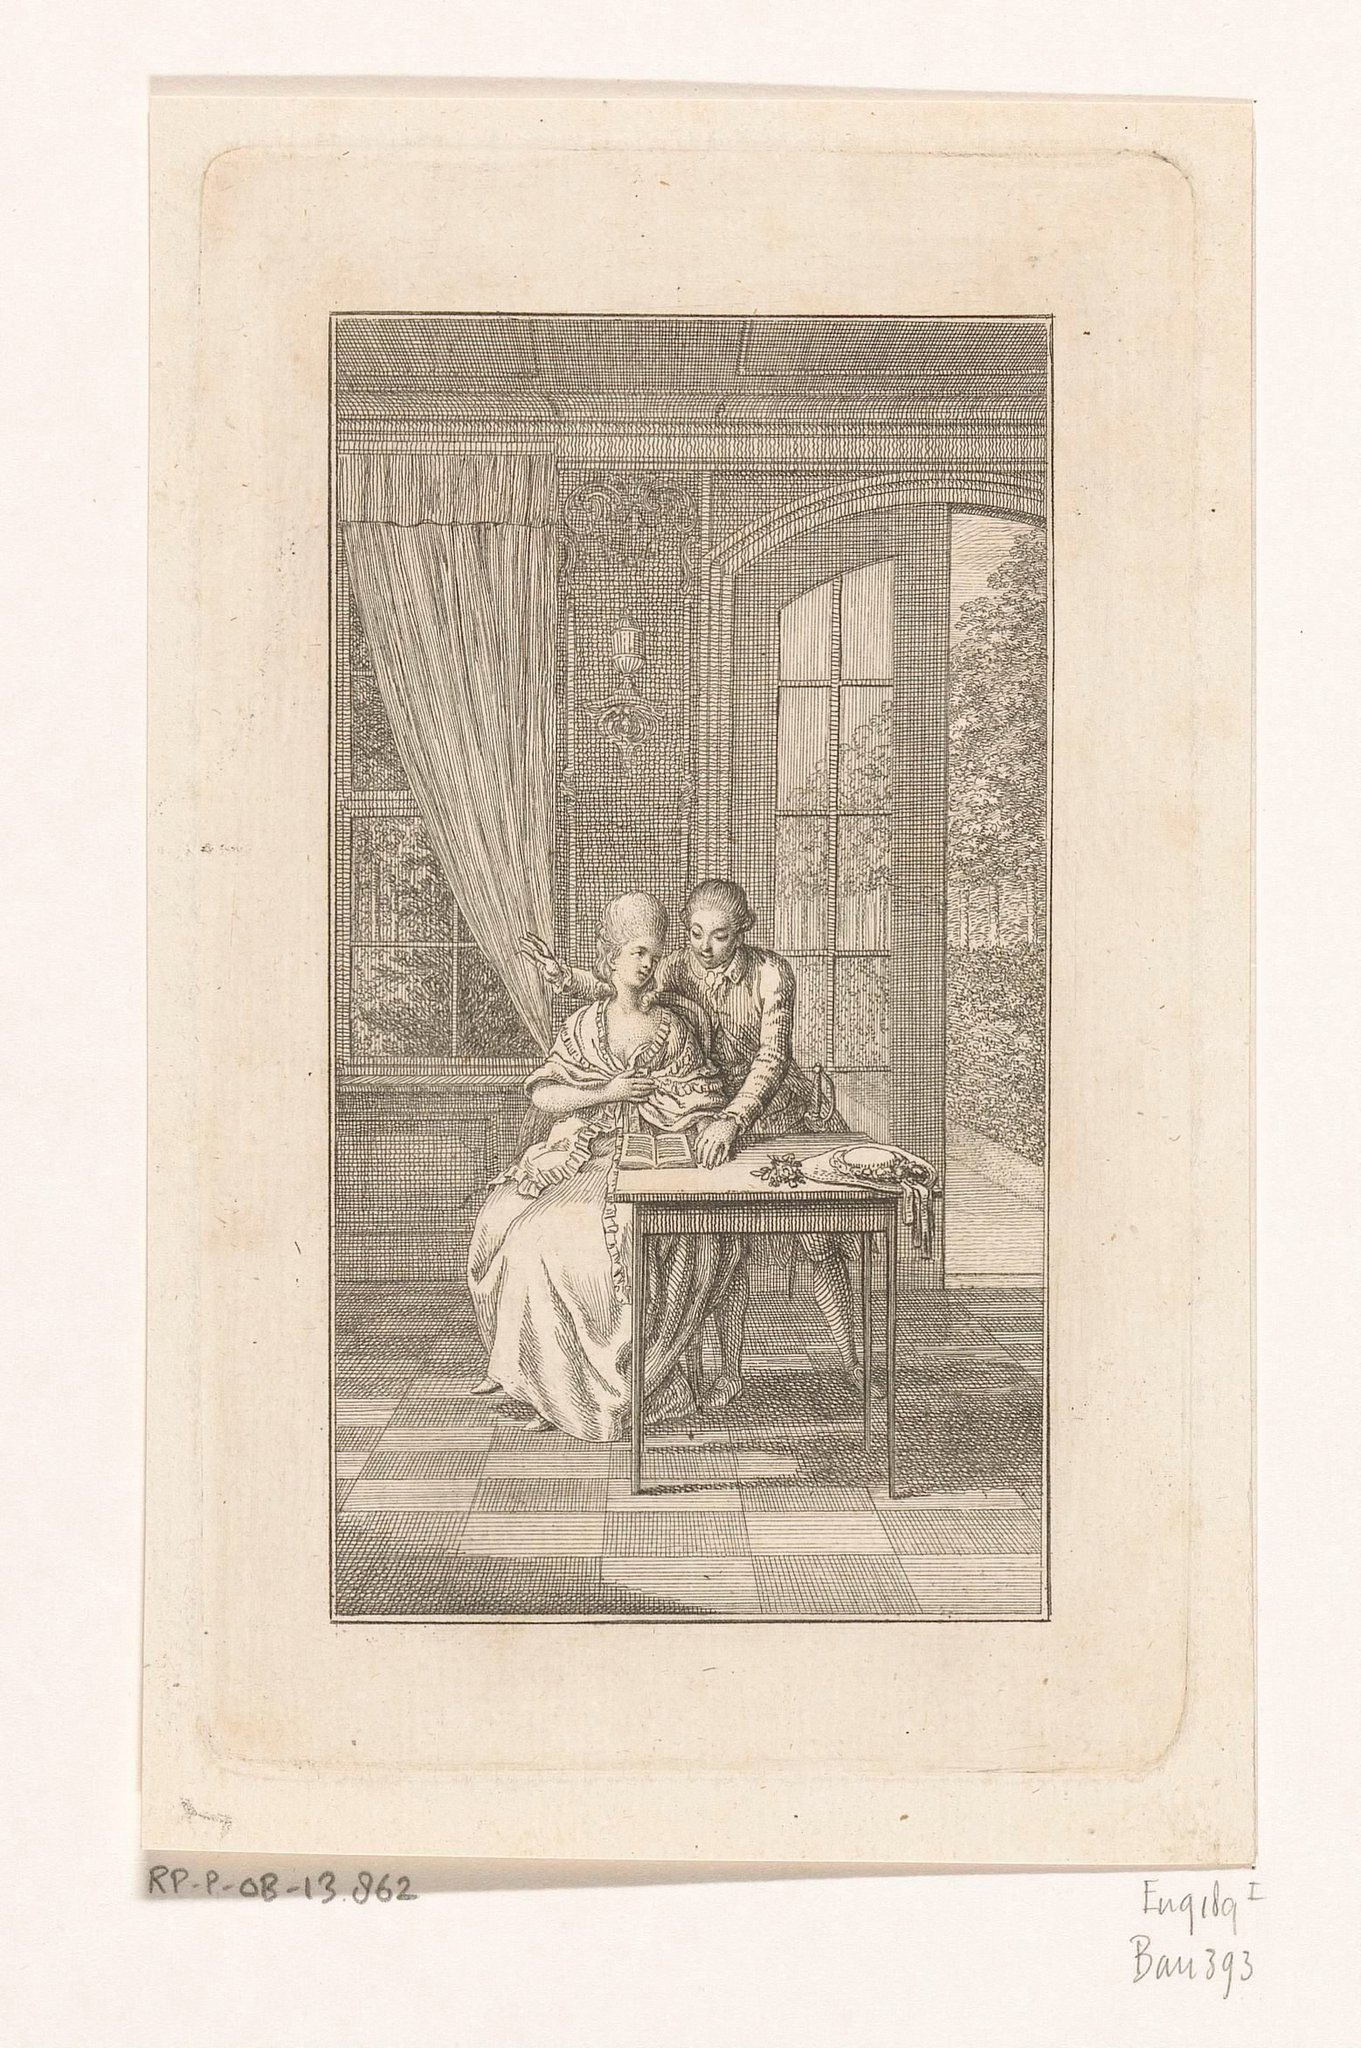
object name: print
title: Carl Ferdiner verrast Julie in het tuinhuis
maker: daniel nikolaus chodowiecki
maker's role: draughtsman, print maker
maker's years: 1726-1801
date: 1777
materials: paper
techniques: etching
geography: berlin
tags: reading, literature, book - mm - book open, summer-house, arbour, garden-house (dutch: 'theekoepel')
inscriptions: collector's mark: Lugt 2228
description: Carl Ferdiner verrast Julie die in het tuinhuis zit te lezen in 'Messias' van Friedrich Gottlieb Klopstock. Wanneer Julie Carl opmerkt trekt ze haar omslagdoek over haar borst.